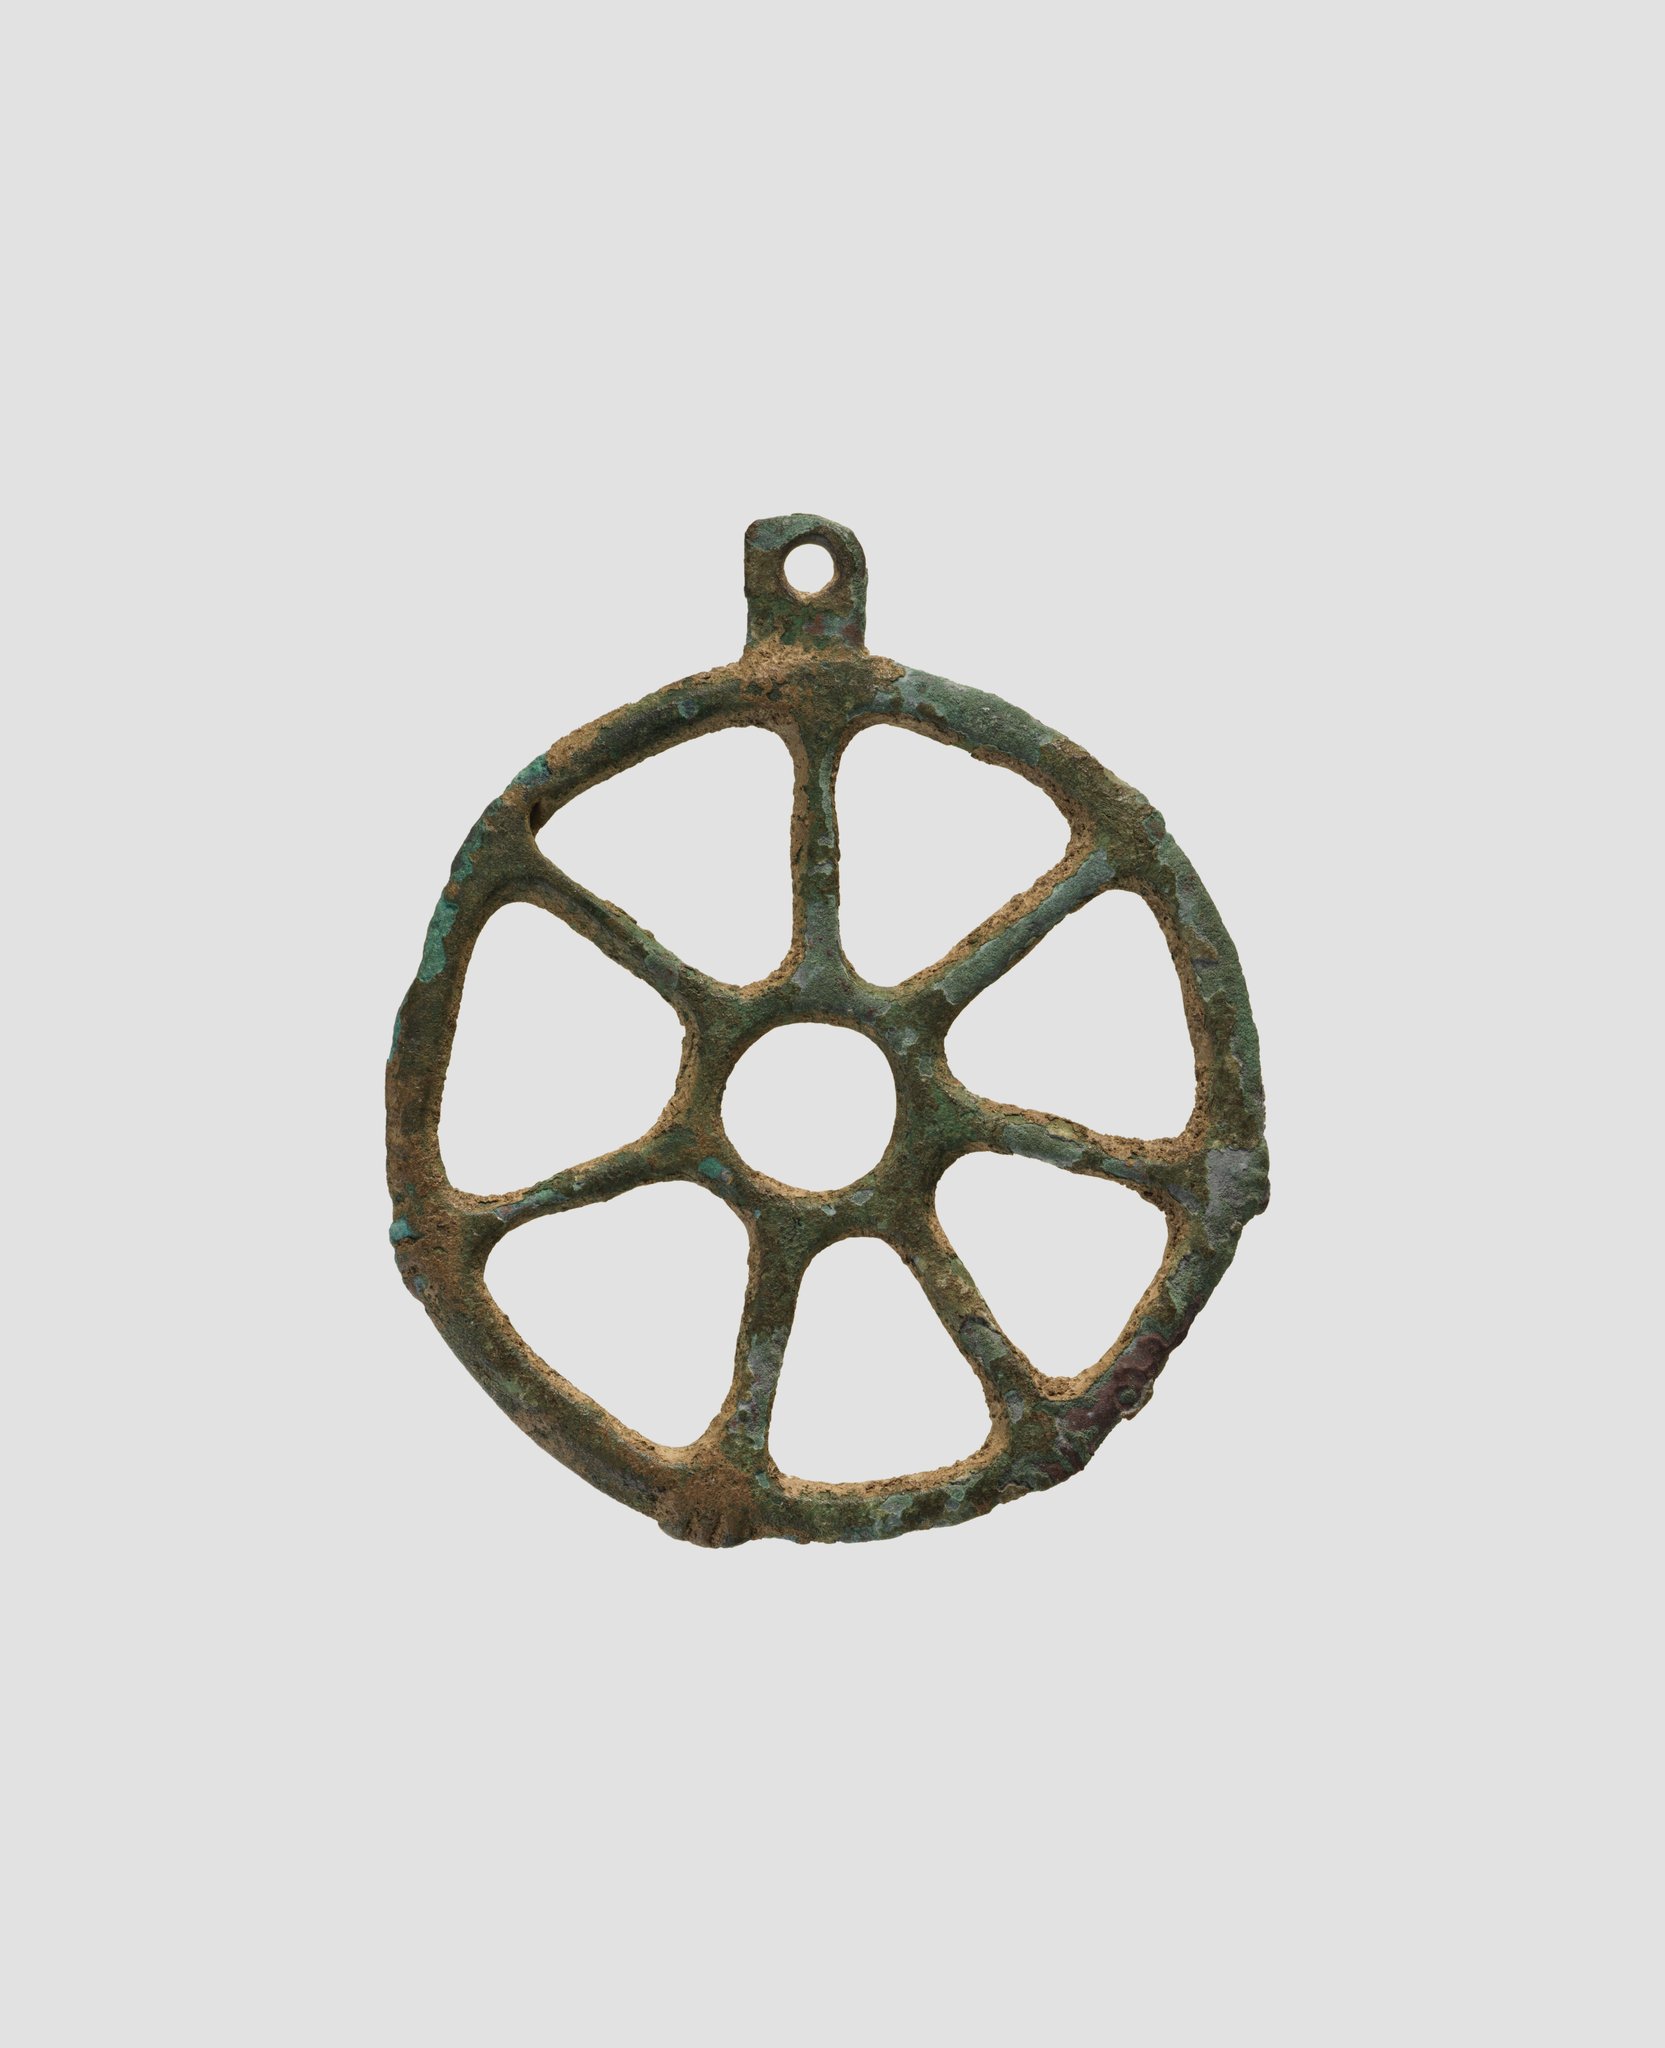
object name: pendant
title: Wheel-shaped pendant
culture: alanic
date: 601-900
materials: metal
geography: caucasus